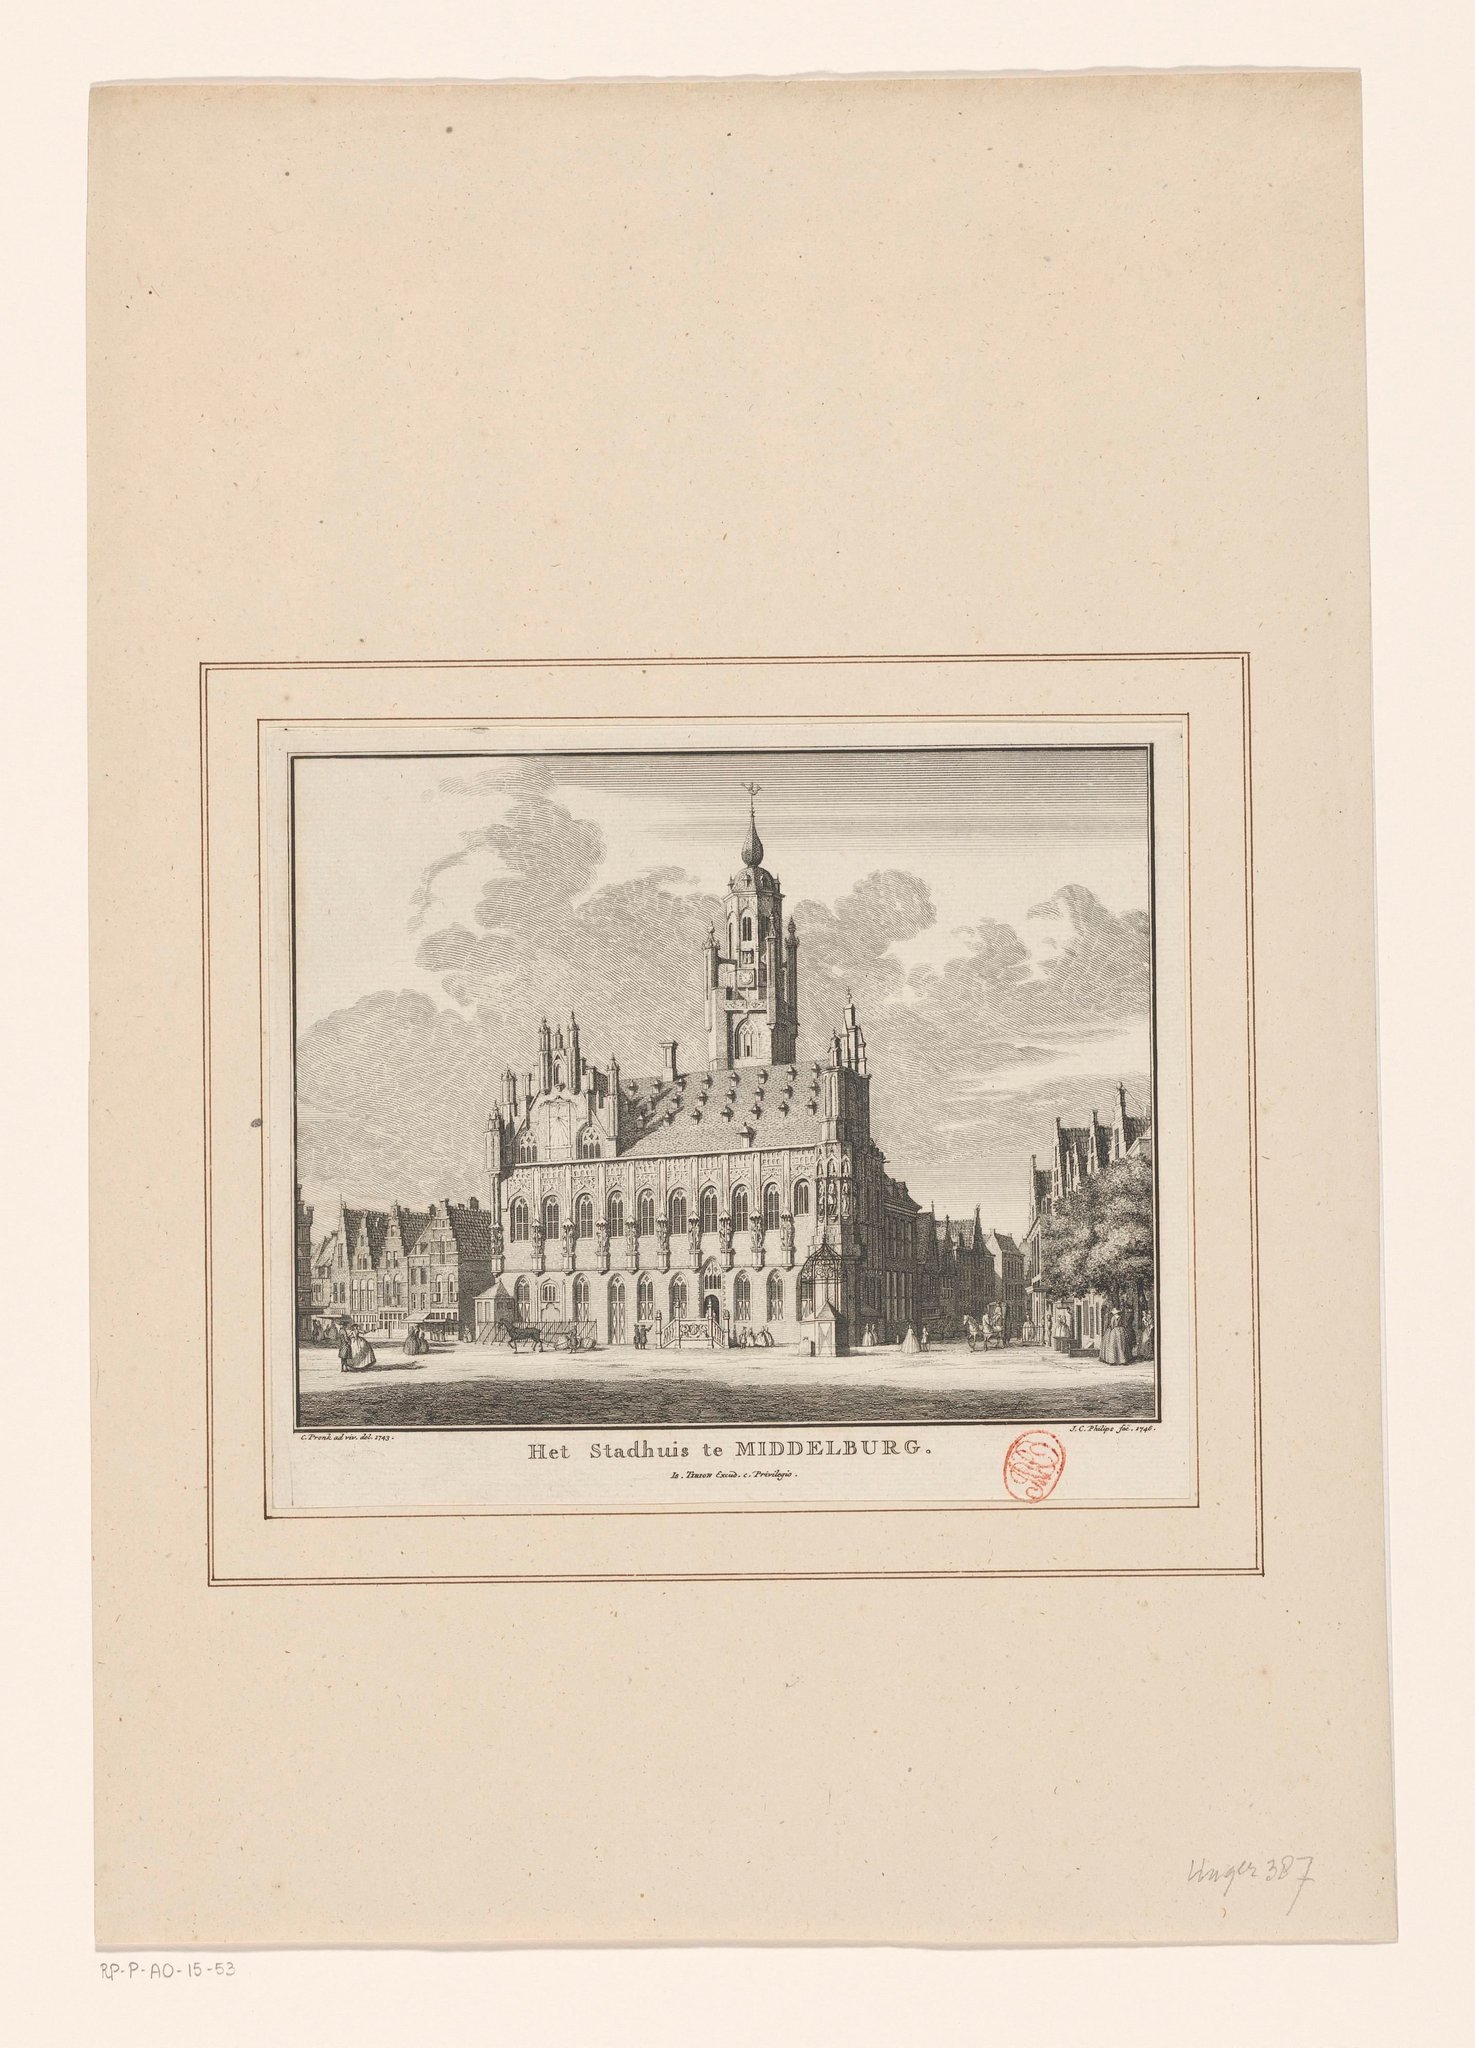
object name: print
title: Gezicht op het stadhuis van Middelburg, 1743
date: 1746-1760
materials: paper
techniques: etching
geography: amsterdam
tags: townhall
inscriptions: collector's mark: Lugt 195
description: Gezicht op het stadhuis van Middelburg, gelegen aan de Markt, in de situatie omstreeks 1743.